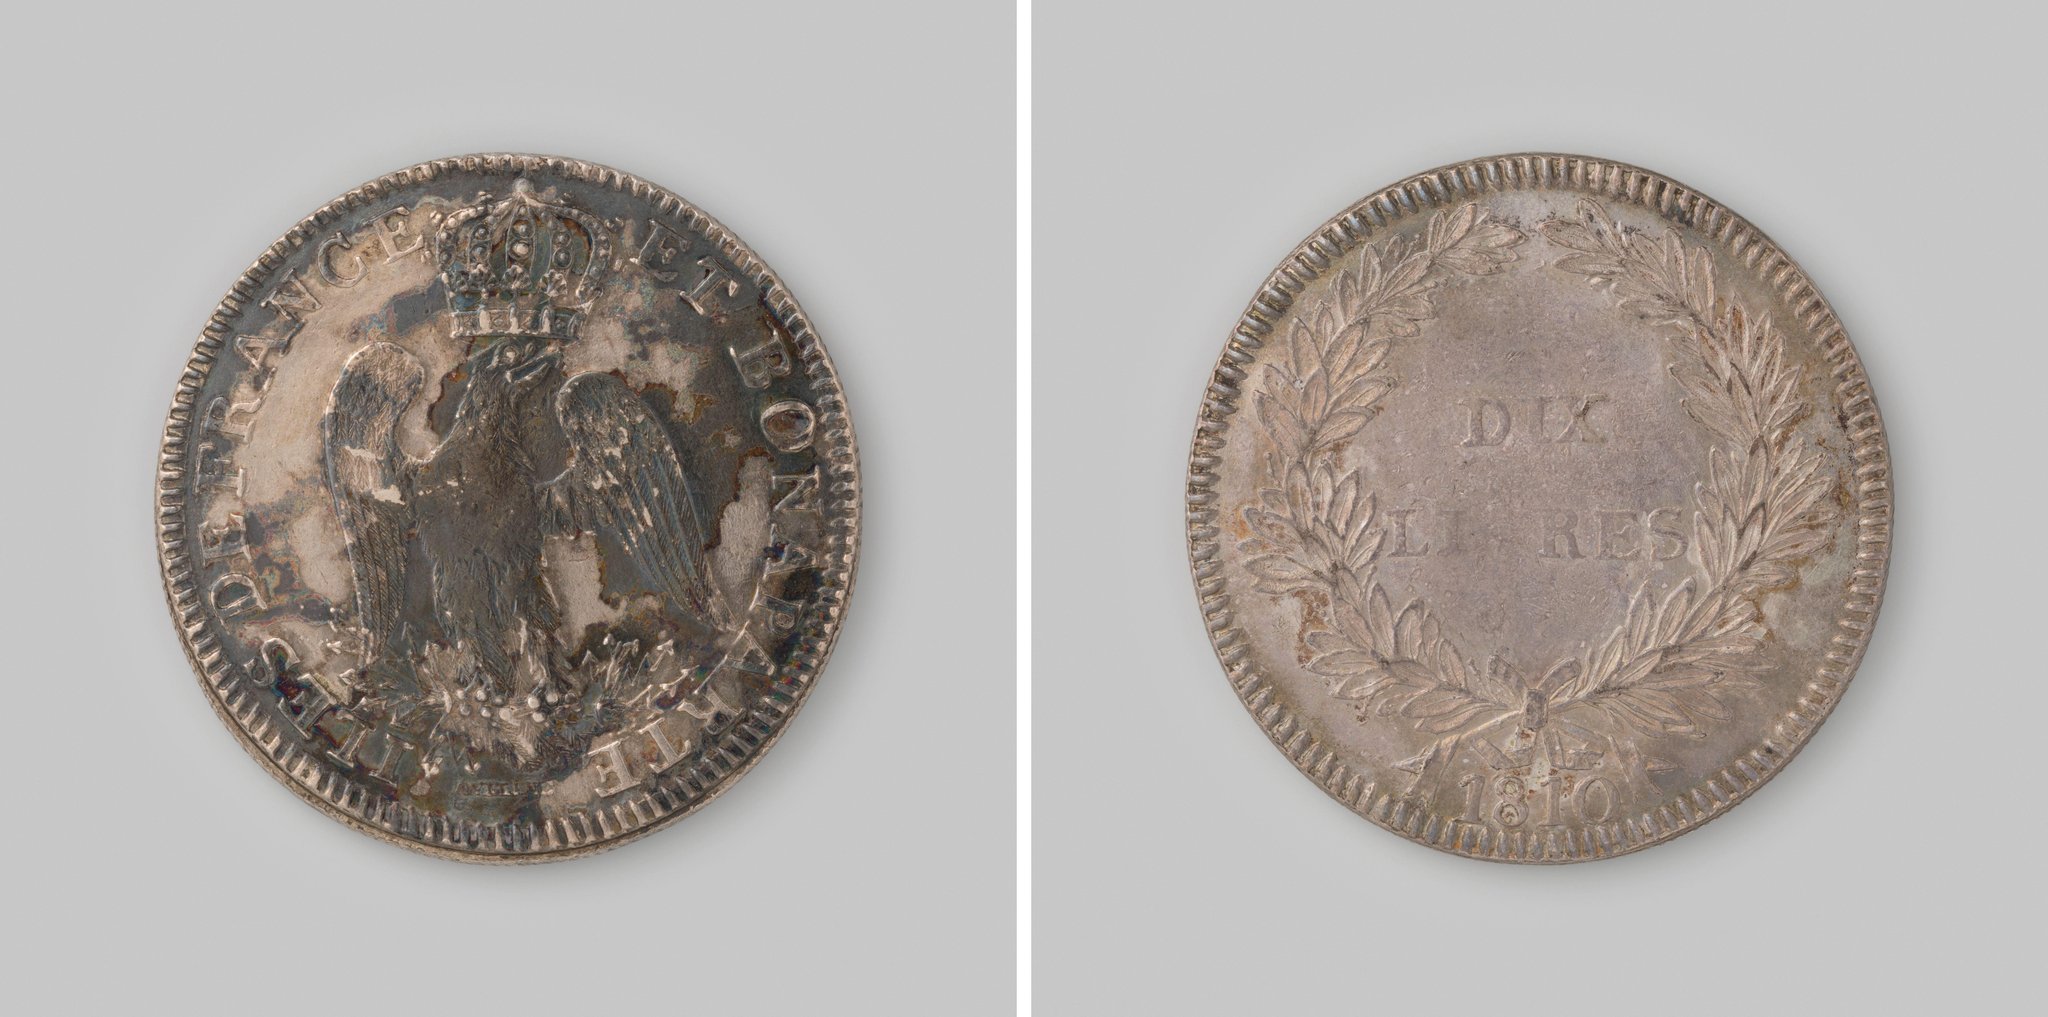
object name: coin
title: 10 livres of piastre van de Iles de France & Bonaparte, 1810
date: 1810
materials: silver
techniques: striking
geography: paris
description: Zilveren munt. Voorzijde: gekroonde adelaar. Omschrift: Iles de France et Bonaparte. Keerzijde: binnen krans in twee regels waarde-aanduiding: dix livres. Onder krans jaartal.